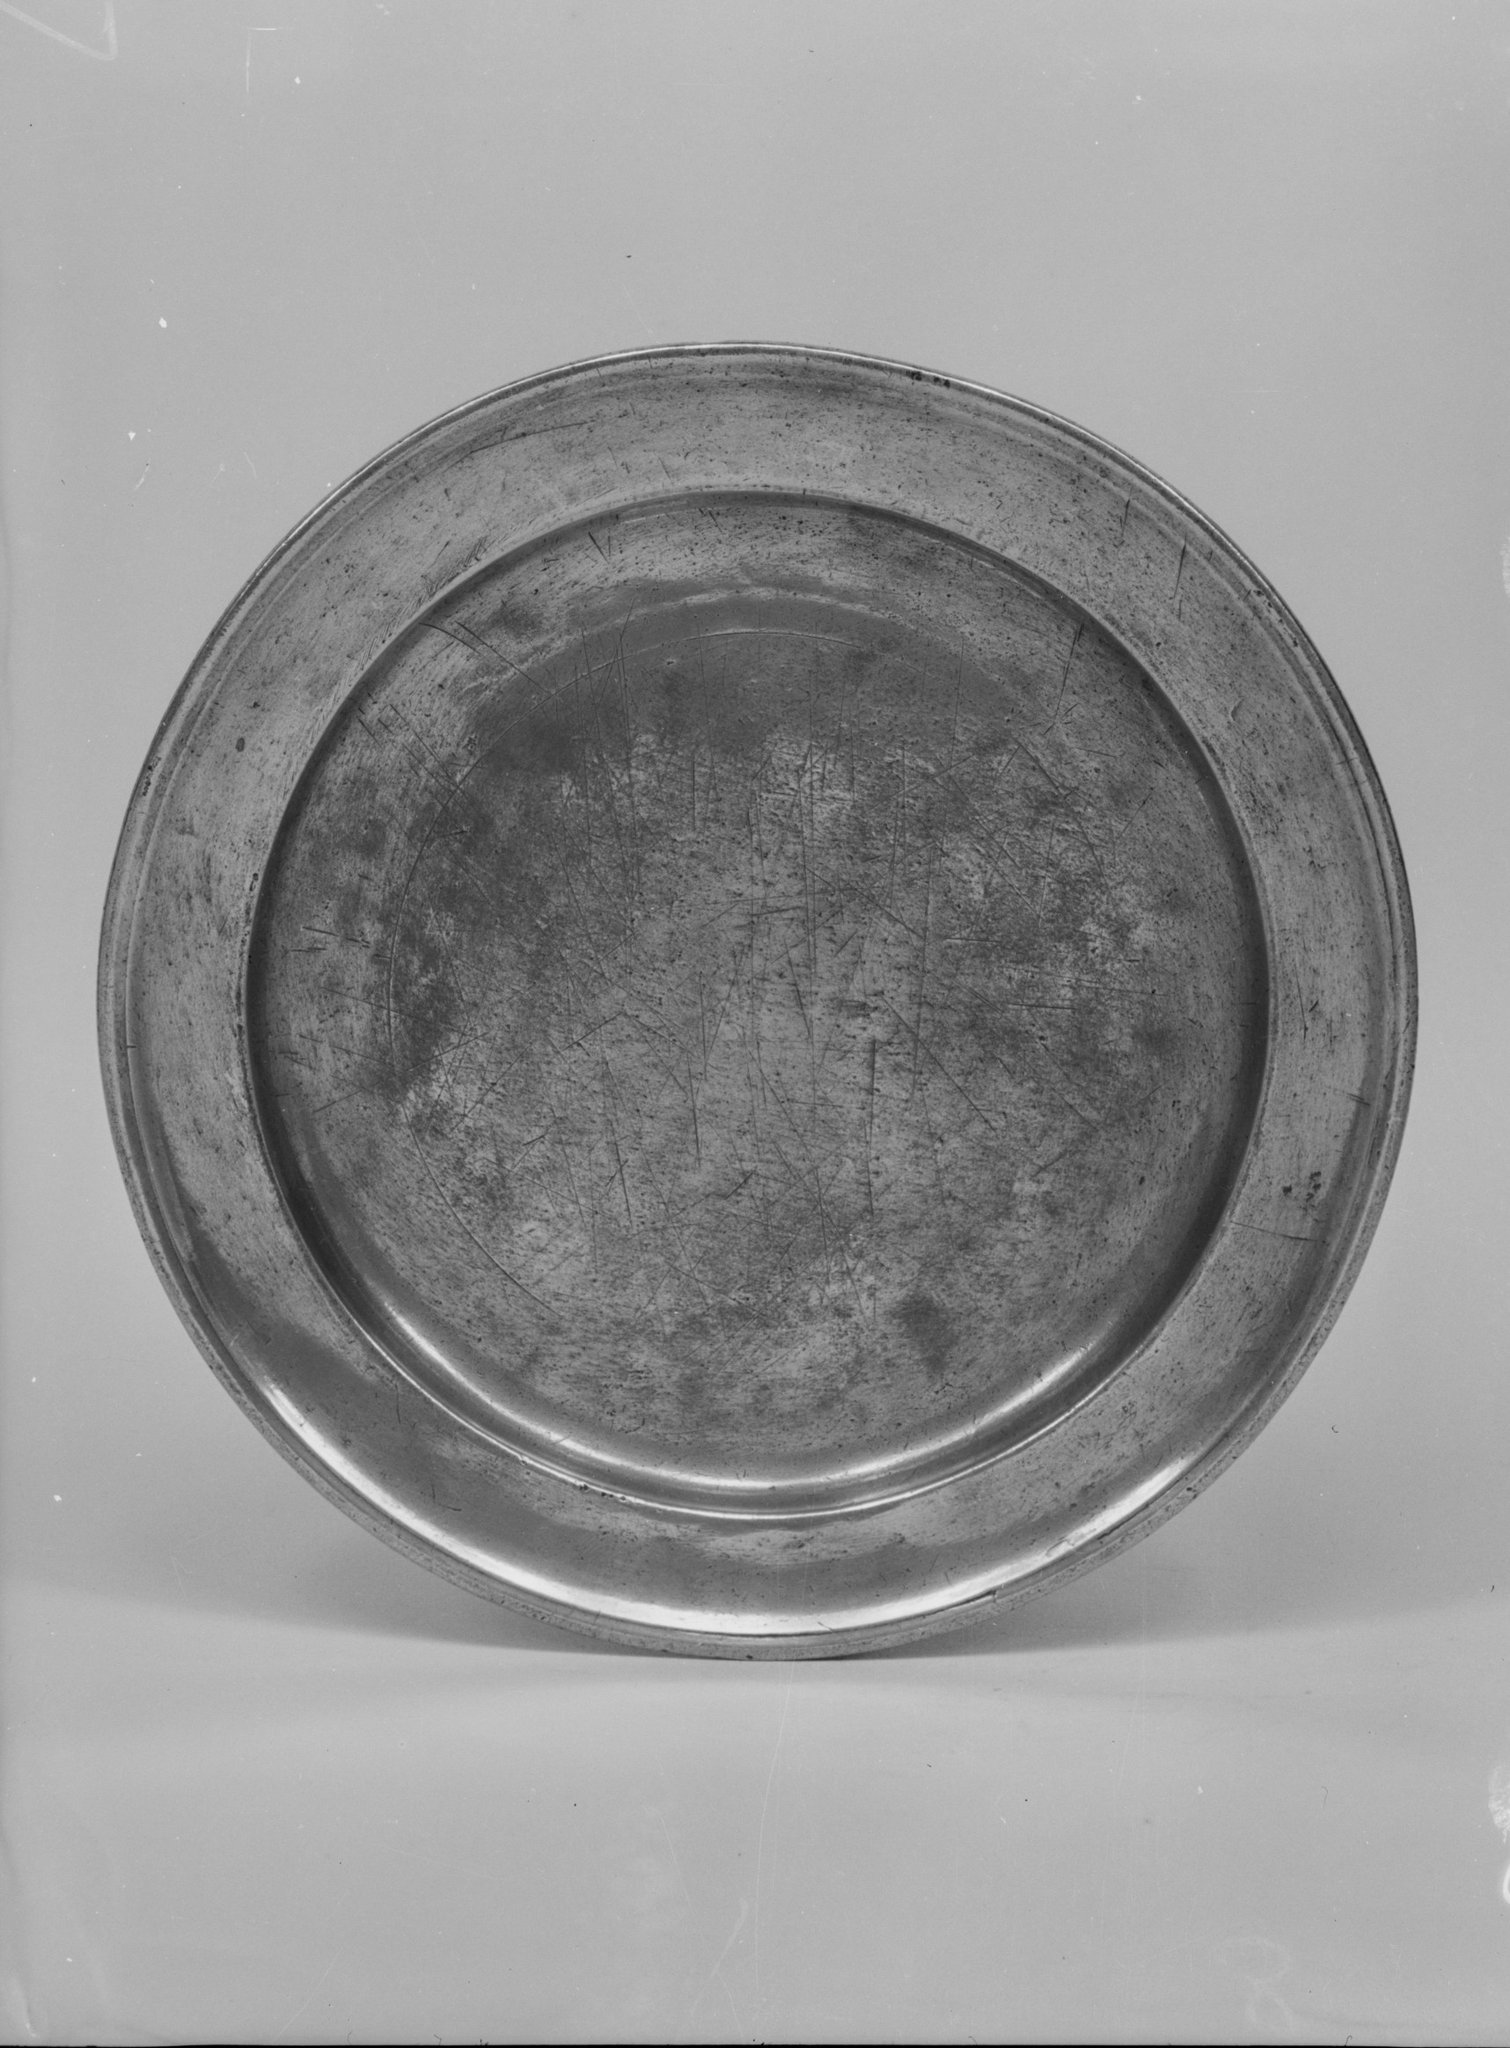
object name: plate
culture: american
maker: david melville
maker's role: maker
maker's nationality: american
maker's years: 1755-1793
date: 1776-1793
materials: pewter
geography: united states